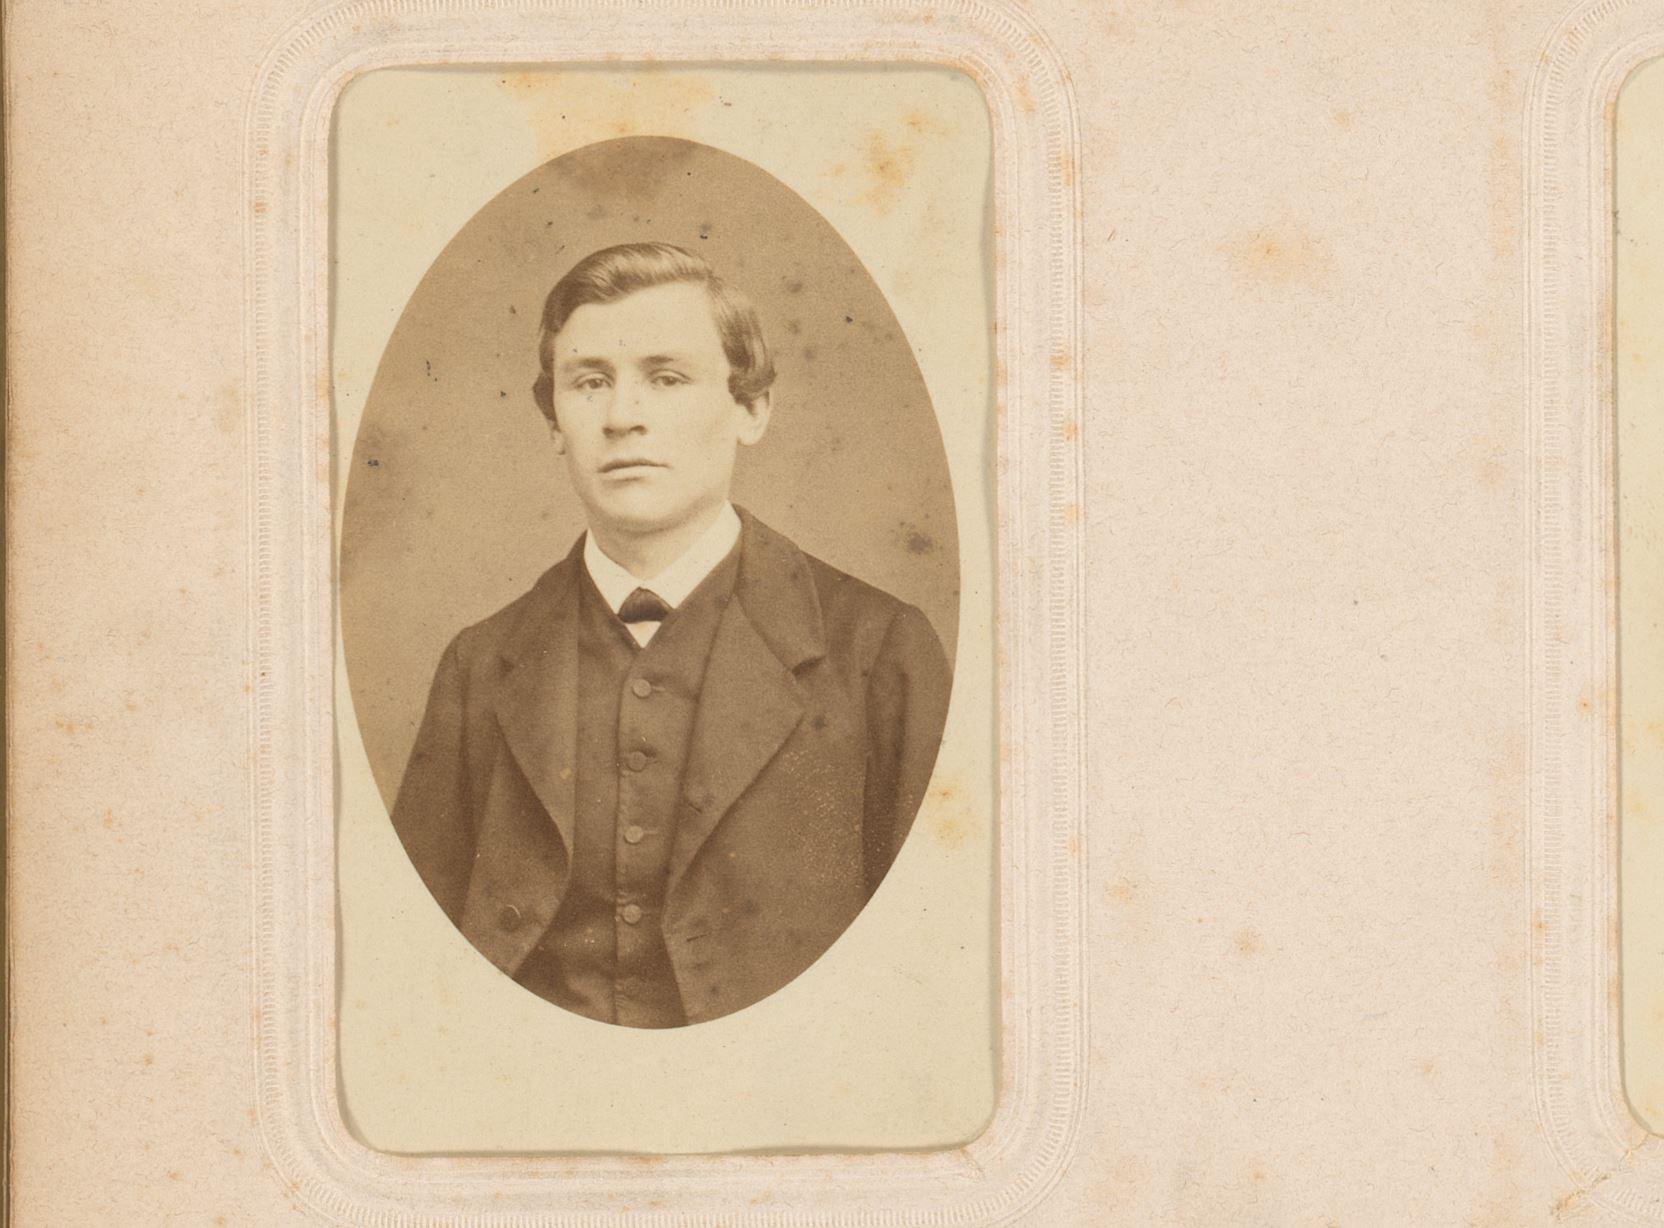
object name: carte de visite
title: Portret van een man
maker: louise daillon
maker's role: fotograaf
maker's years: 1839-1876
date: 1860-1900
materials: cardboard, photographic support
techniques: albumen print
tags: adult man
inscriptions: inscription: ‘Photographie du Saumon/ L. Daillon/ 59, Rue Montmartre 59/ Paris’